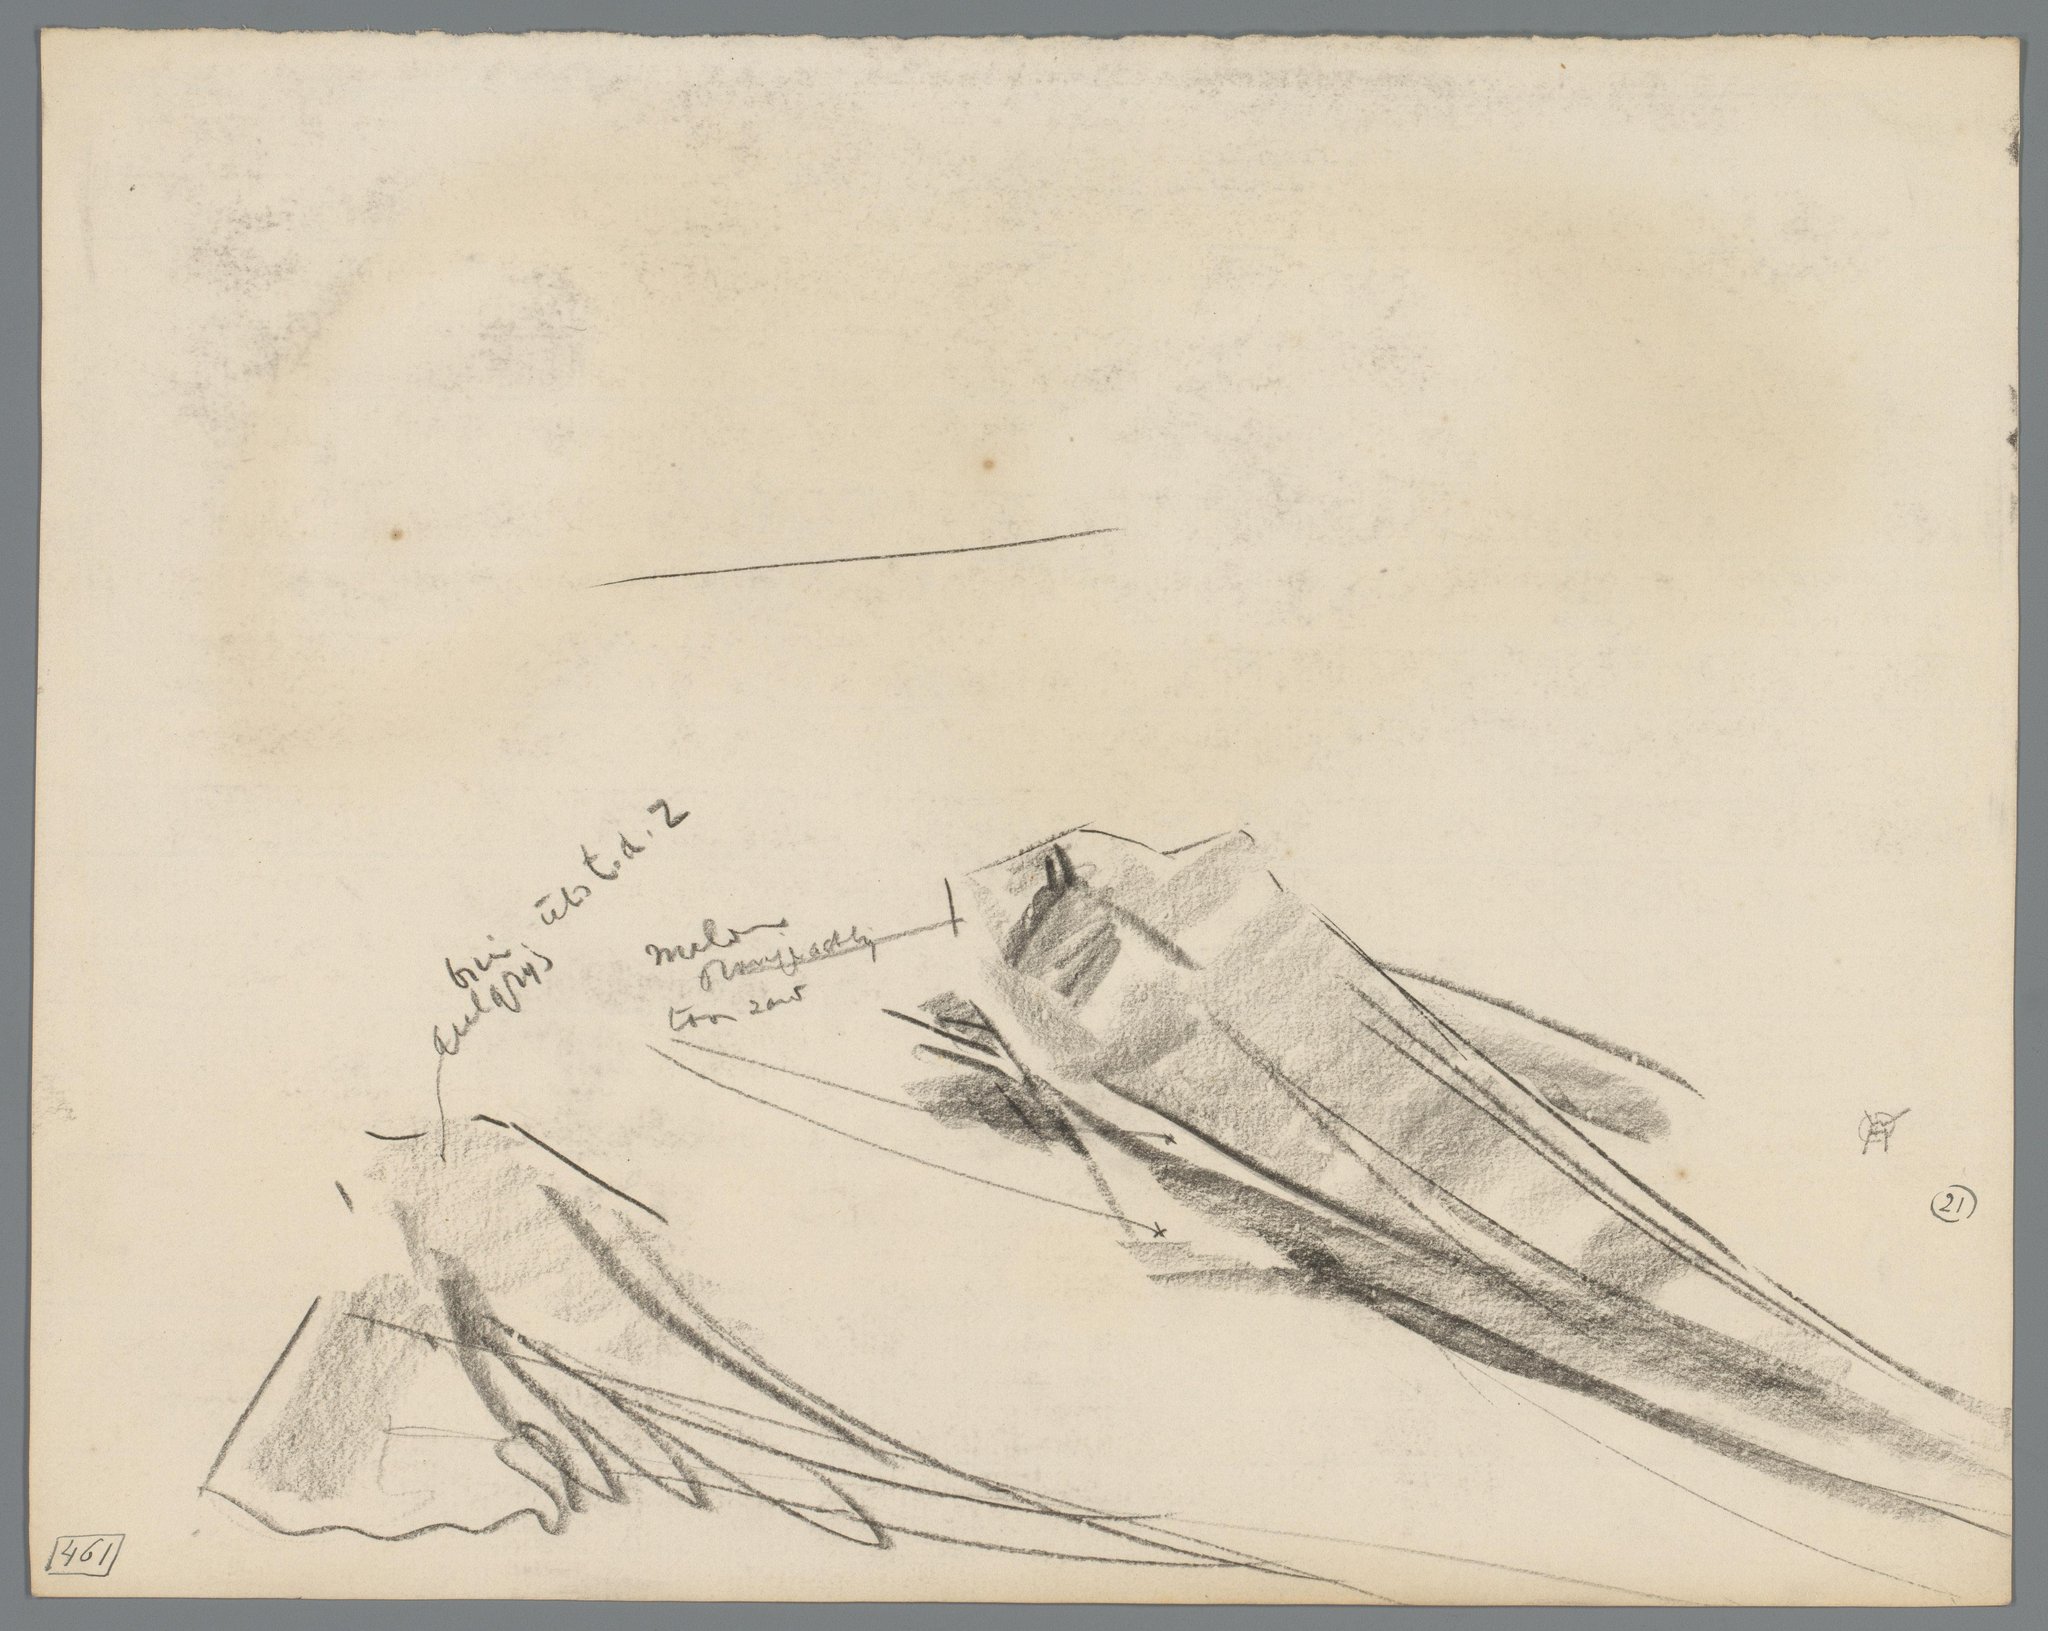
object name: drawing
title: Studie van een rode poon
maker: gerrit willem dijsselhof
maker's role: designer, draughtsman, print maker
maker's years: 1866-1924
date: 1876-1924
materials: chalk, paper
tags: fishes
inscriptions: number: ‘461’, number: ‘21’